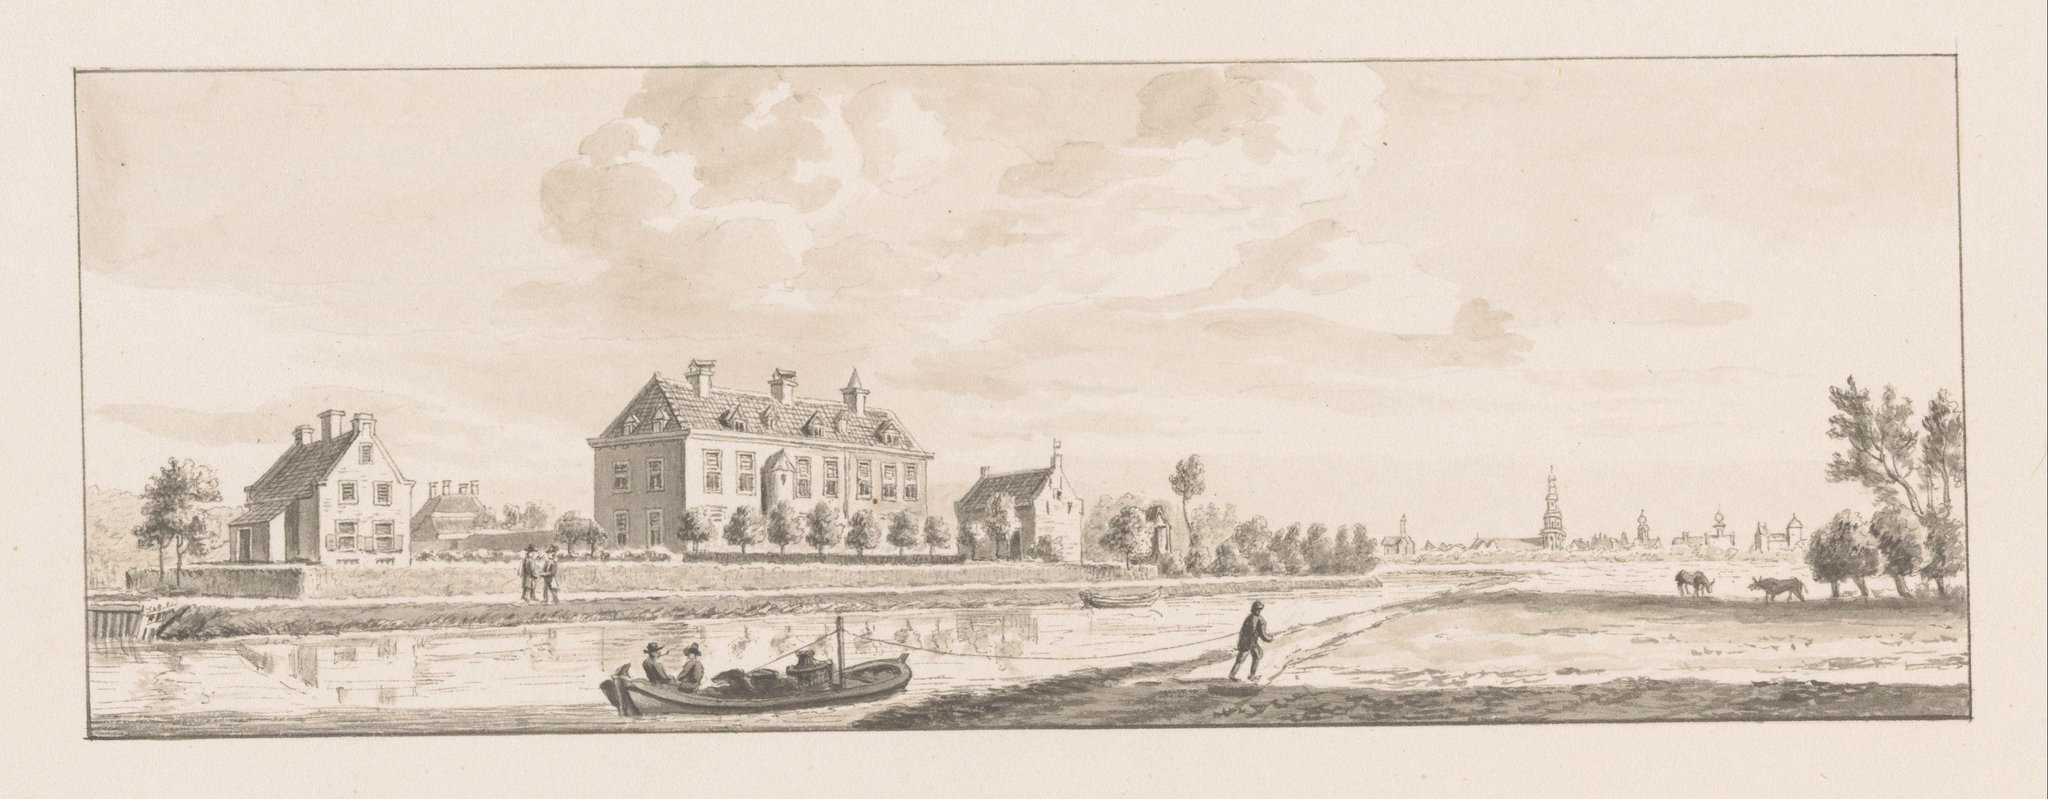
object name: drawing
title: Gezicht op het huis 's Heerendijk bij IJsselstein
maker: Anonymous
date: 1750-1850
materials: ink, paper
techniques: brush, drawing, pen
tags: canal, tow-boat, towing-barge, farm or solitary house in landscape